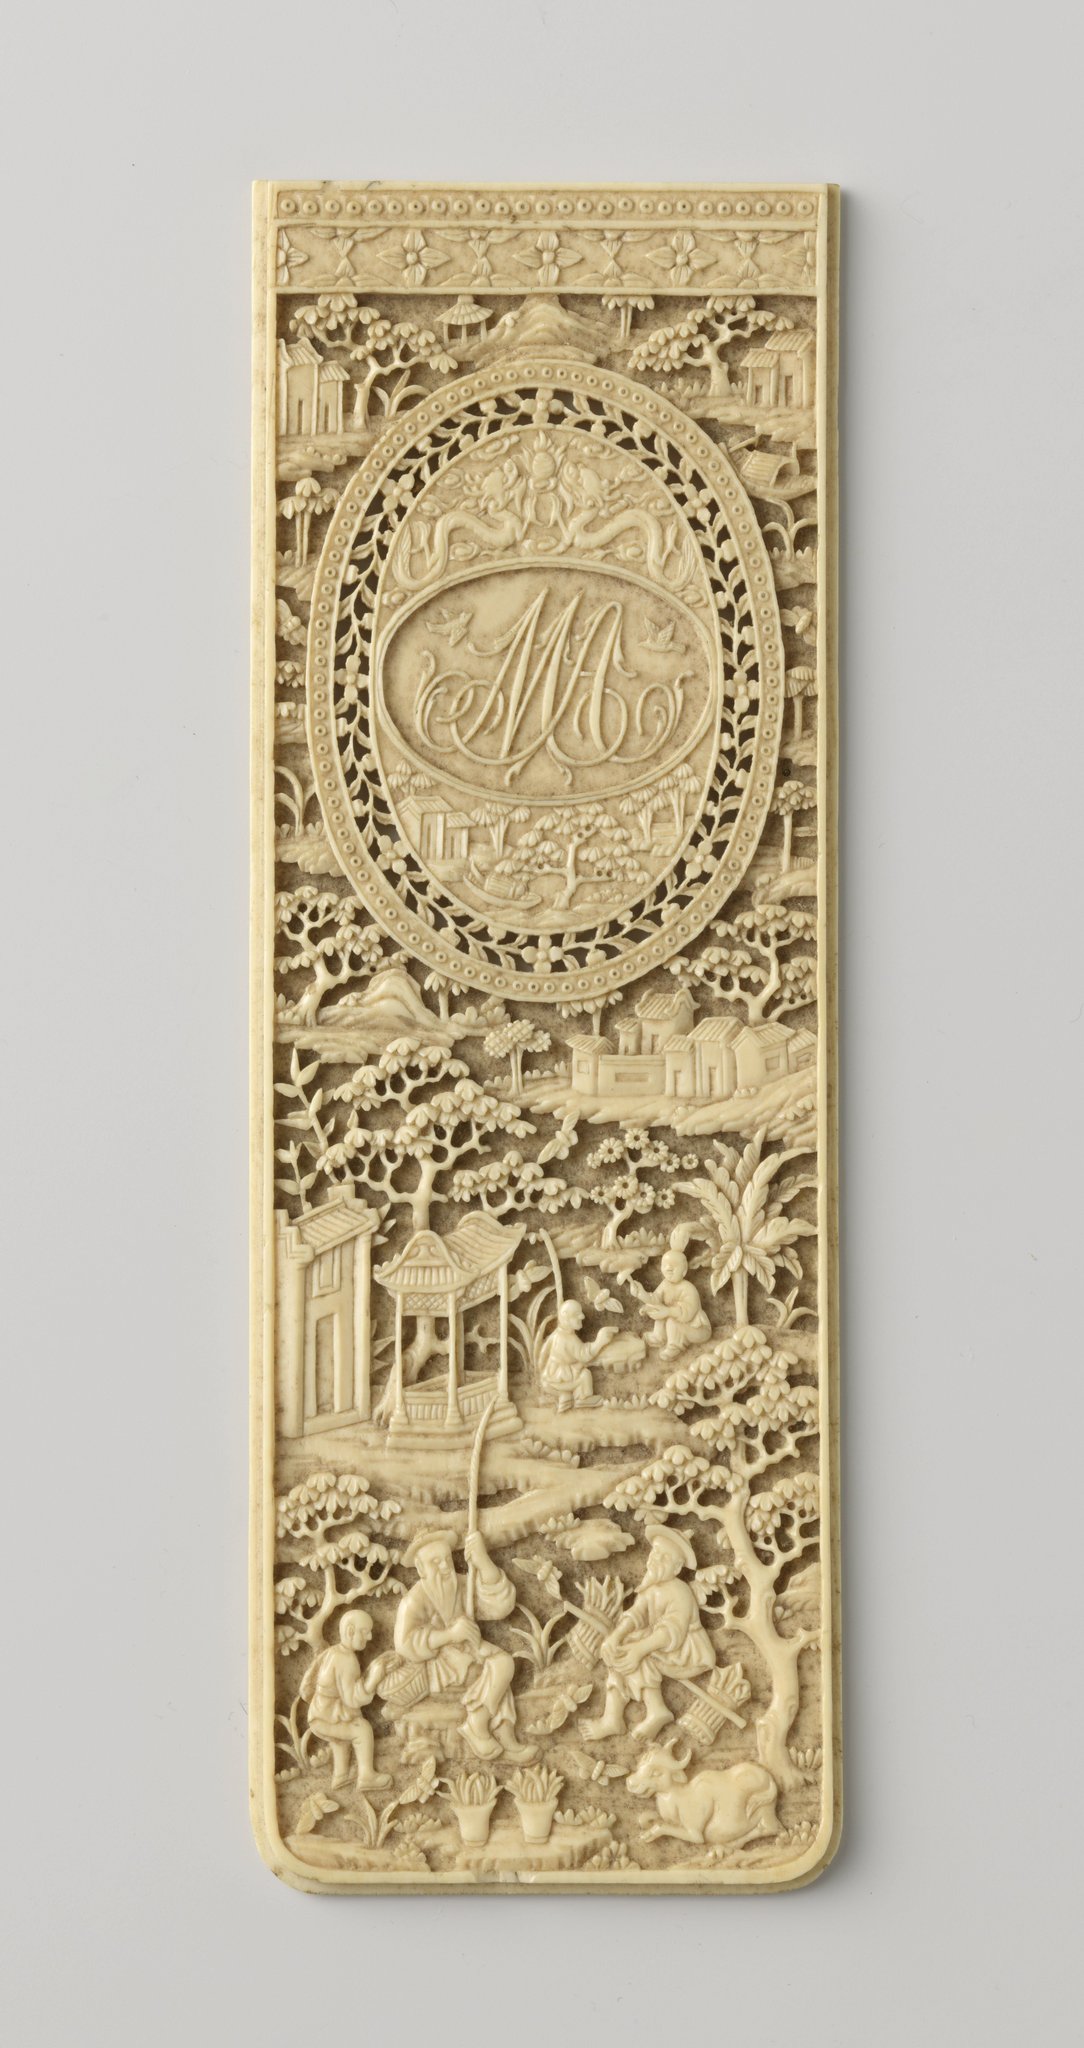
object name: lid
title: Ivoren deksel met oosters landschap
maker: Anonymous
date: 1750-1800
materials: ivory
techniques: cutting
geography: china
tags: enkhuizen, dragon (large fabulous serpent, sometimes with wings and legs), china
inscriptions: inscription: ‘M.A.’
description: Ivoren langwerpig deksel met midden-boven een monogram M.A. en twee vogels in een liggend ovaal. Hieromheen een groter, staand ovaal met opengewerkte rankenrand en een smalle noppen-band. Daarbinnen, aan de bovenzijde twee draken, en aan de onderzijde een landschap. De rest van het deksel is gesneden in diep reliëf met een landschap met bomen, gebouwen, figuren en onderaan een liggende koe.